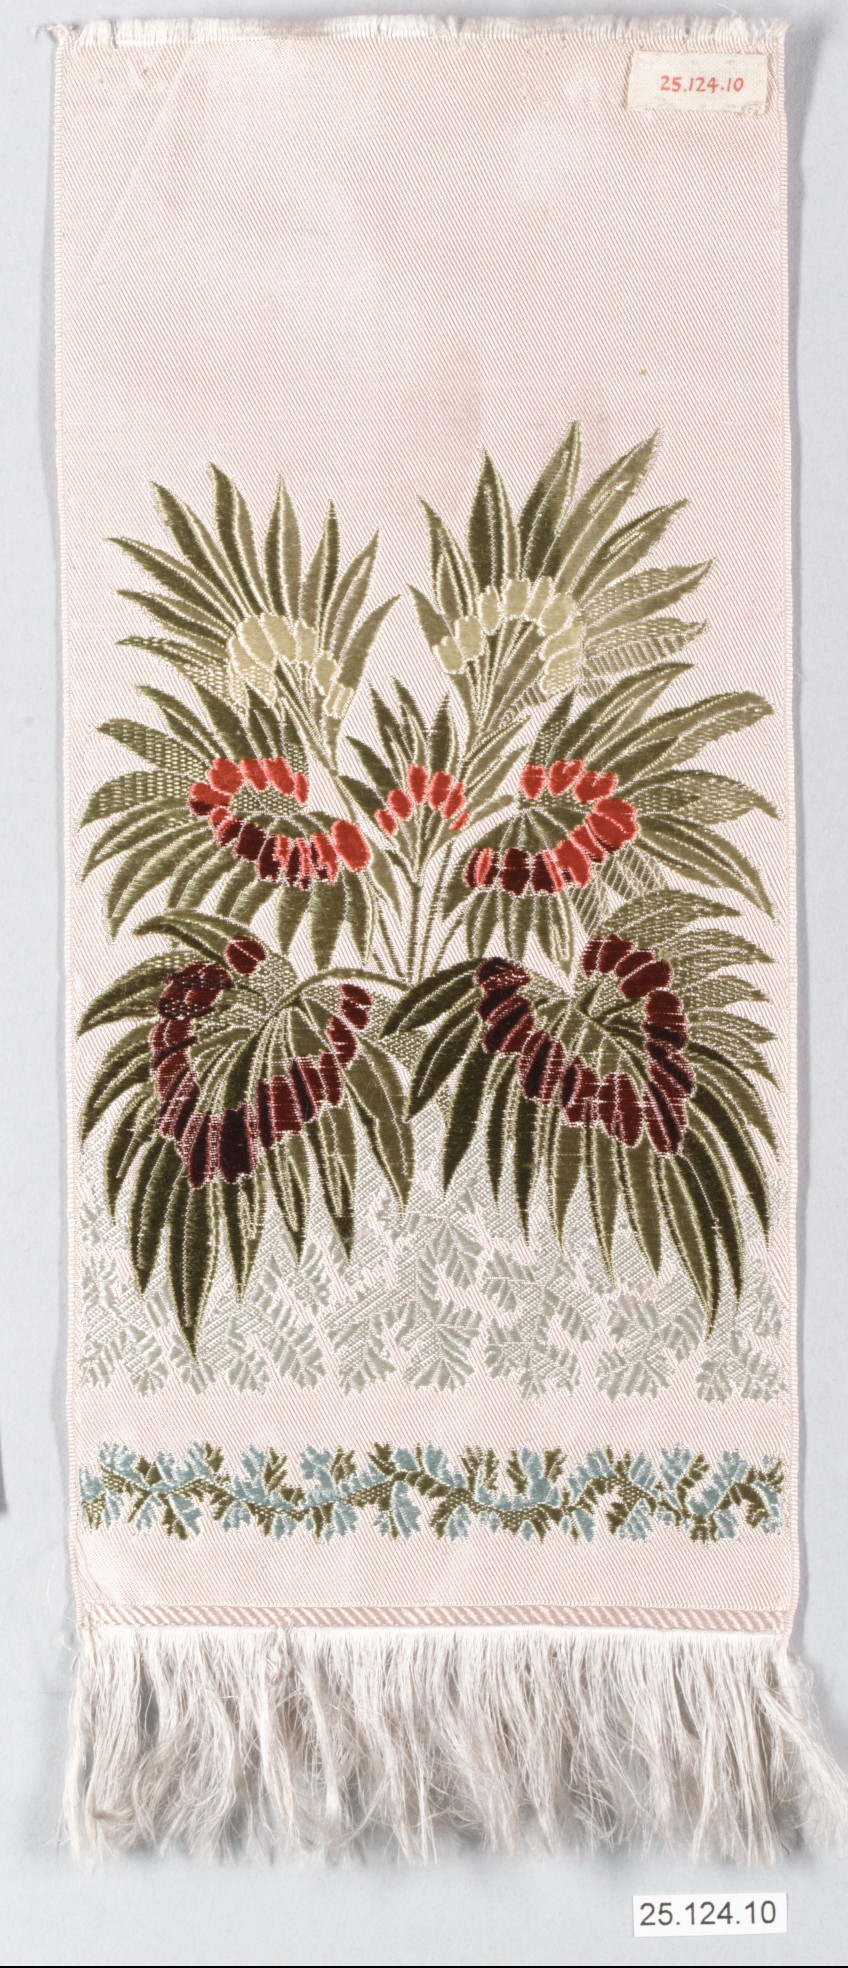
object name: necktie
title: Woman's necktie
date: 1870-1880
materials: silk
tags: leaves